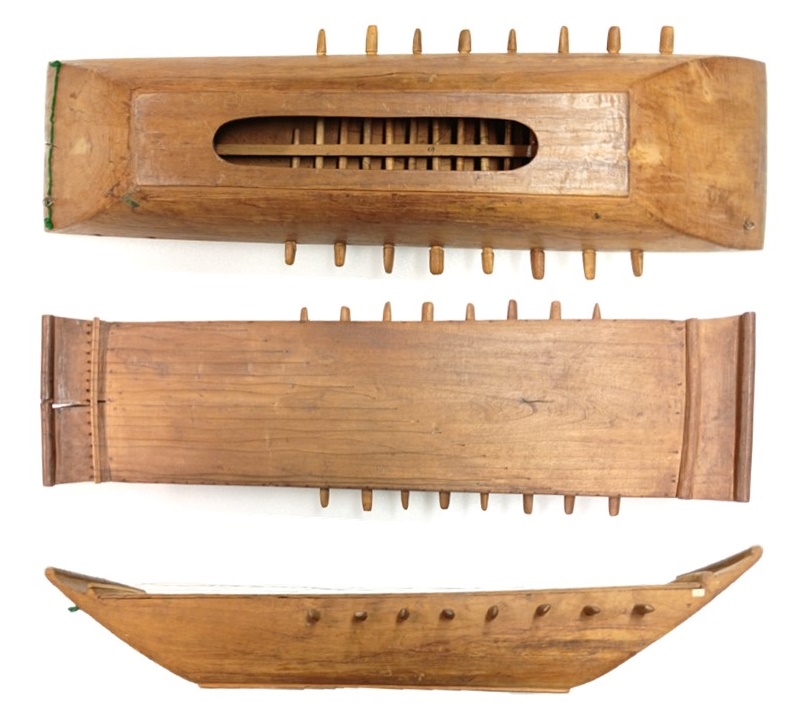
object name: kechapi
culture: javanese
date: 1867-1900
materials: textile, metal, wood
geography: indonesia